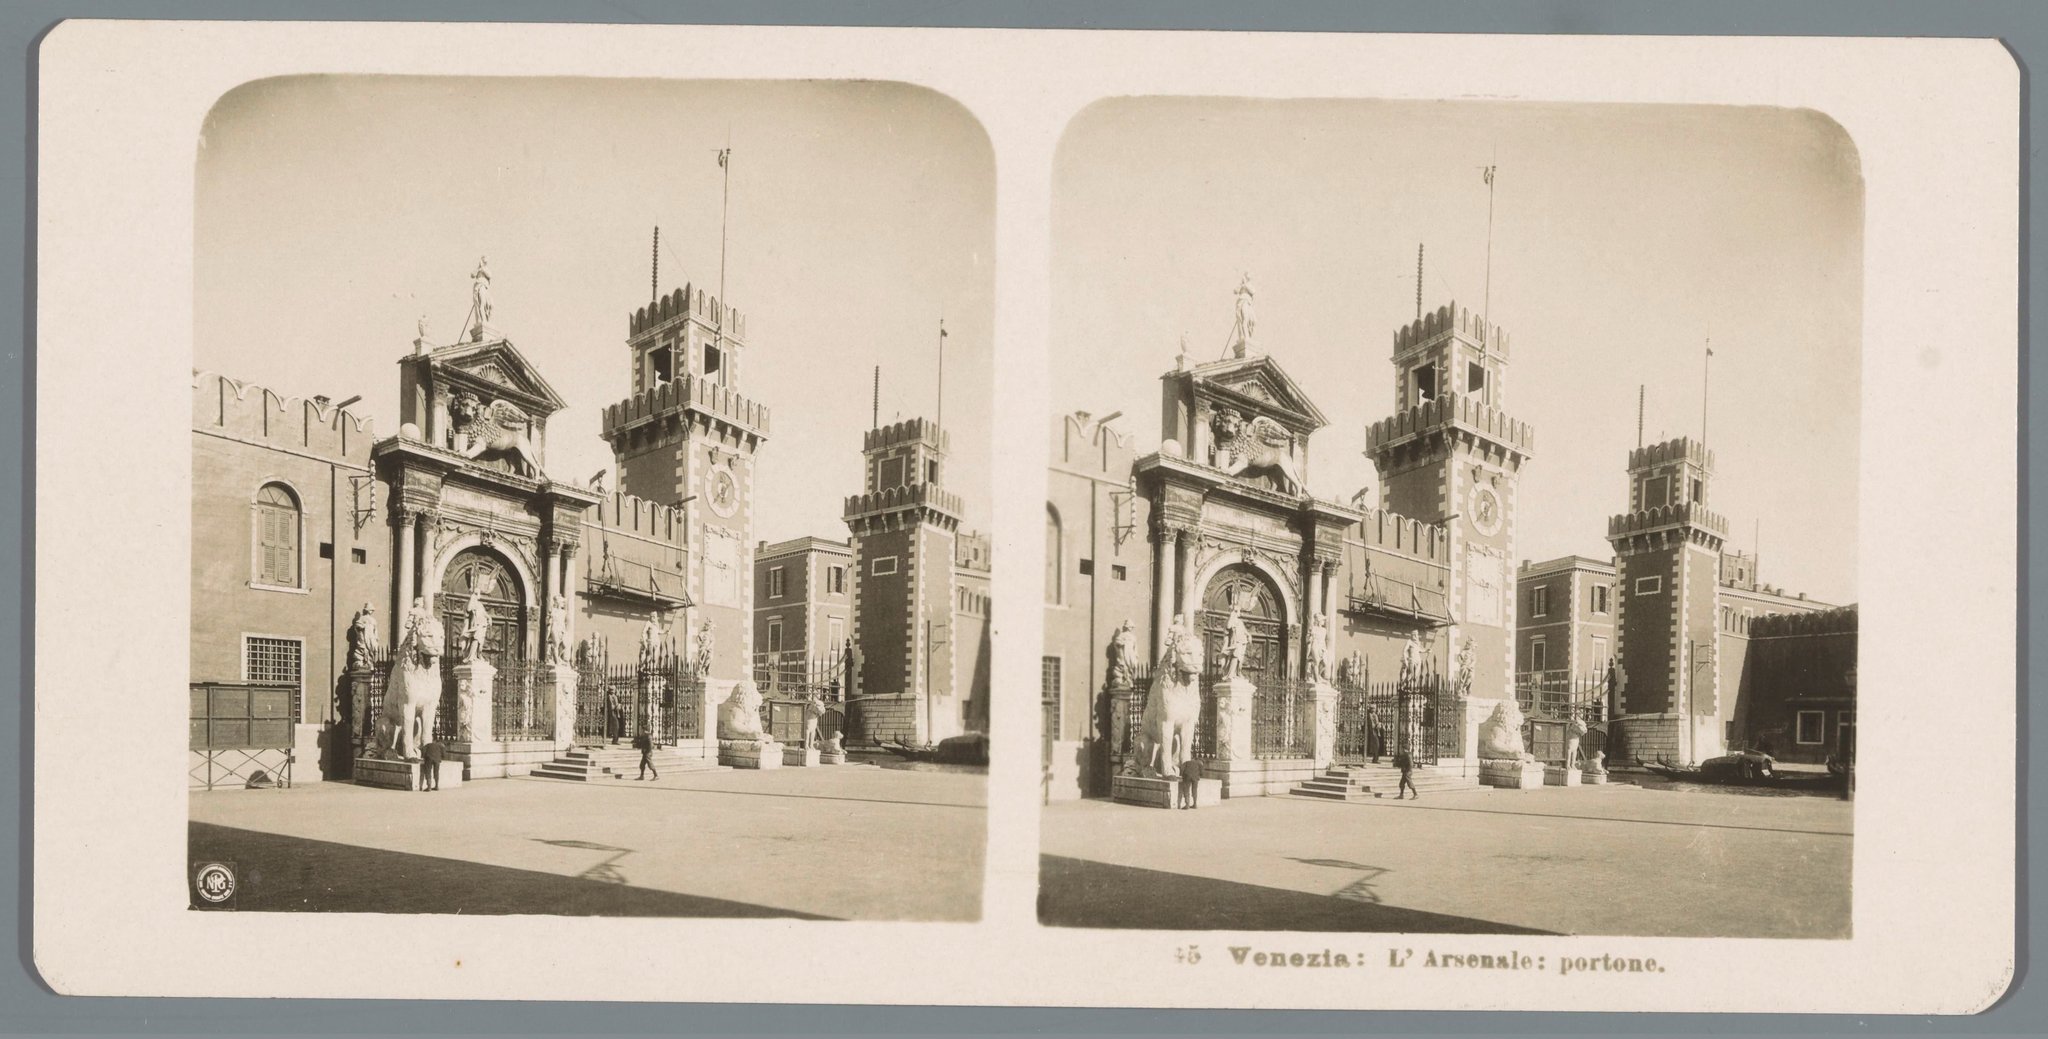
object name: stereograph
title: Venezia: L'arsenale: portone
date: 1900-1910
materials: cardboard, photographic support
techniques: gelatin silver print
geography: venice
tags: gate, entrance, shipyard, shipdock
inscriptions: inscription: ‘NPG’, number: ‘45’